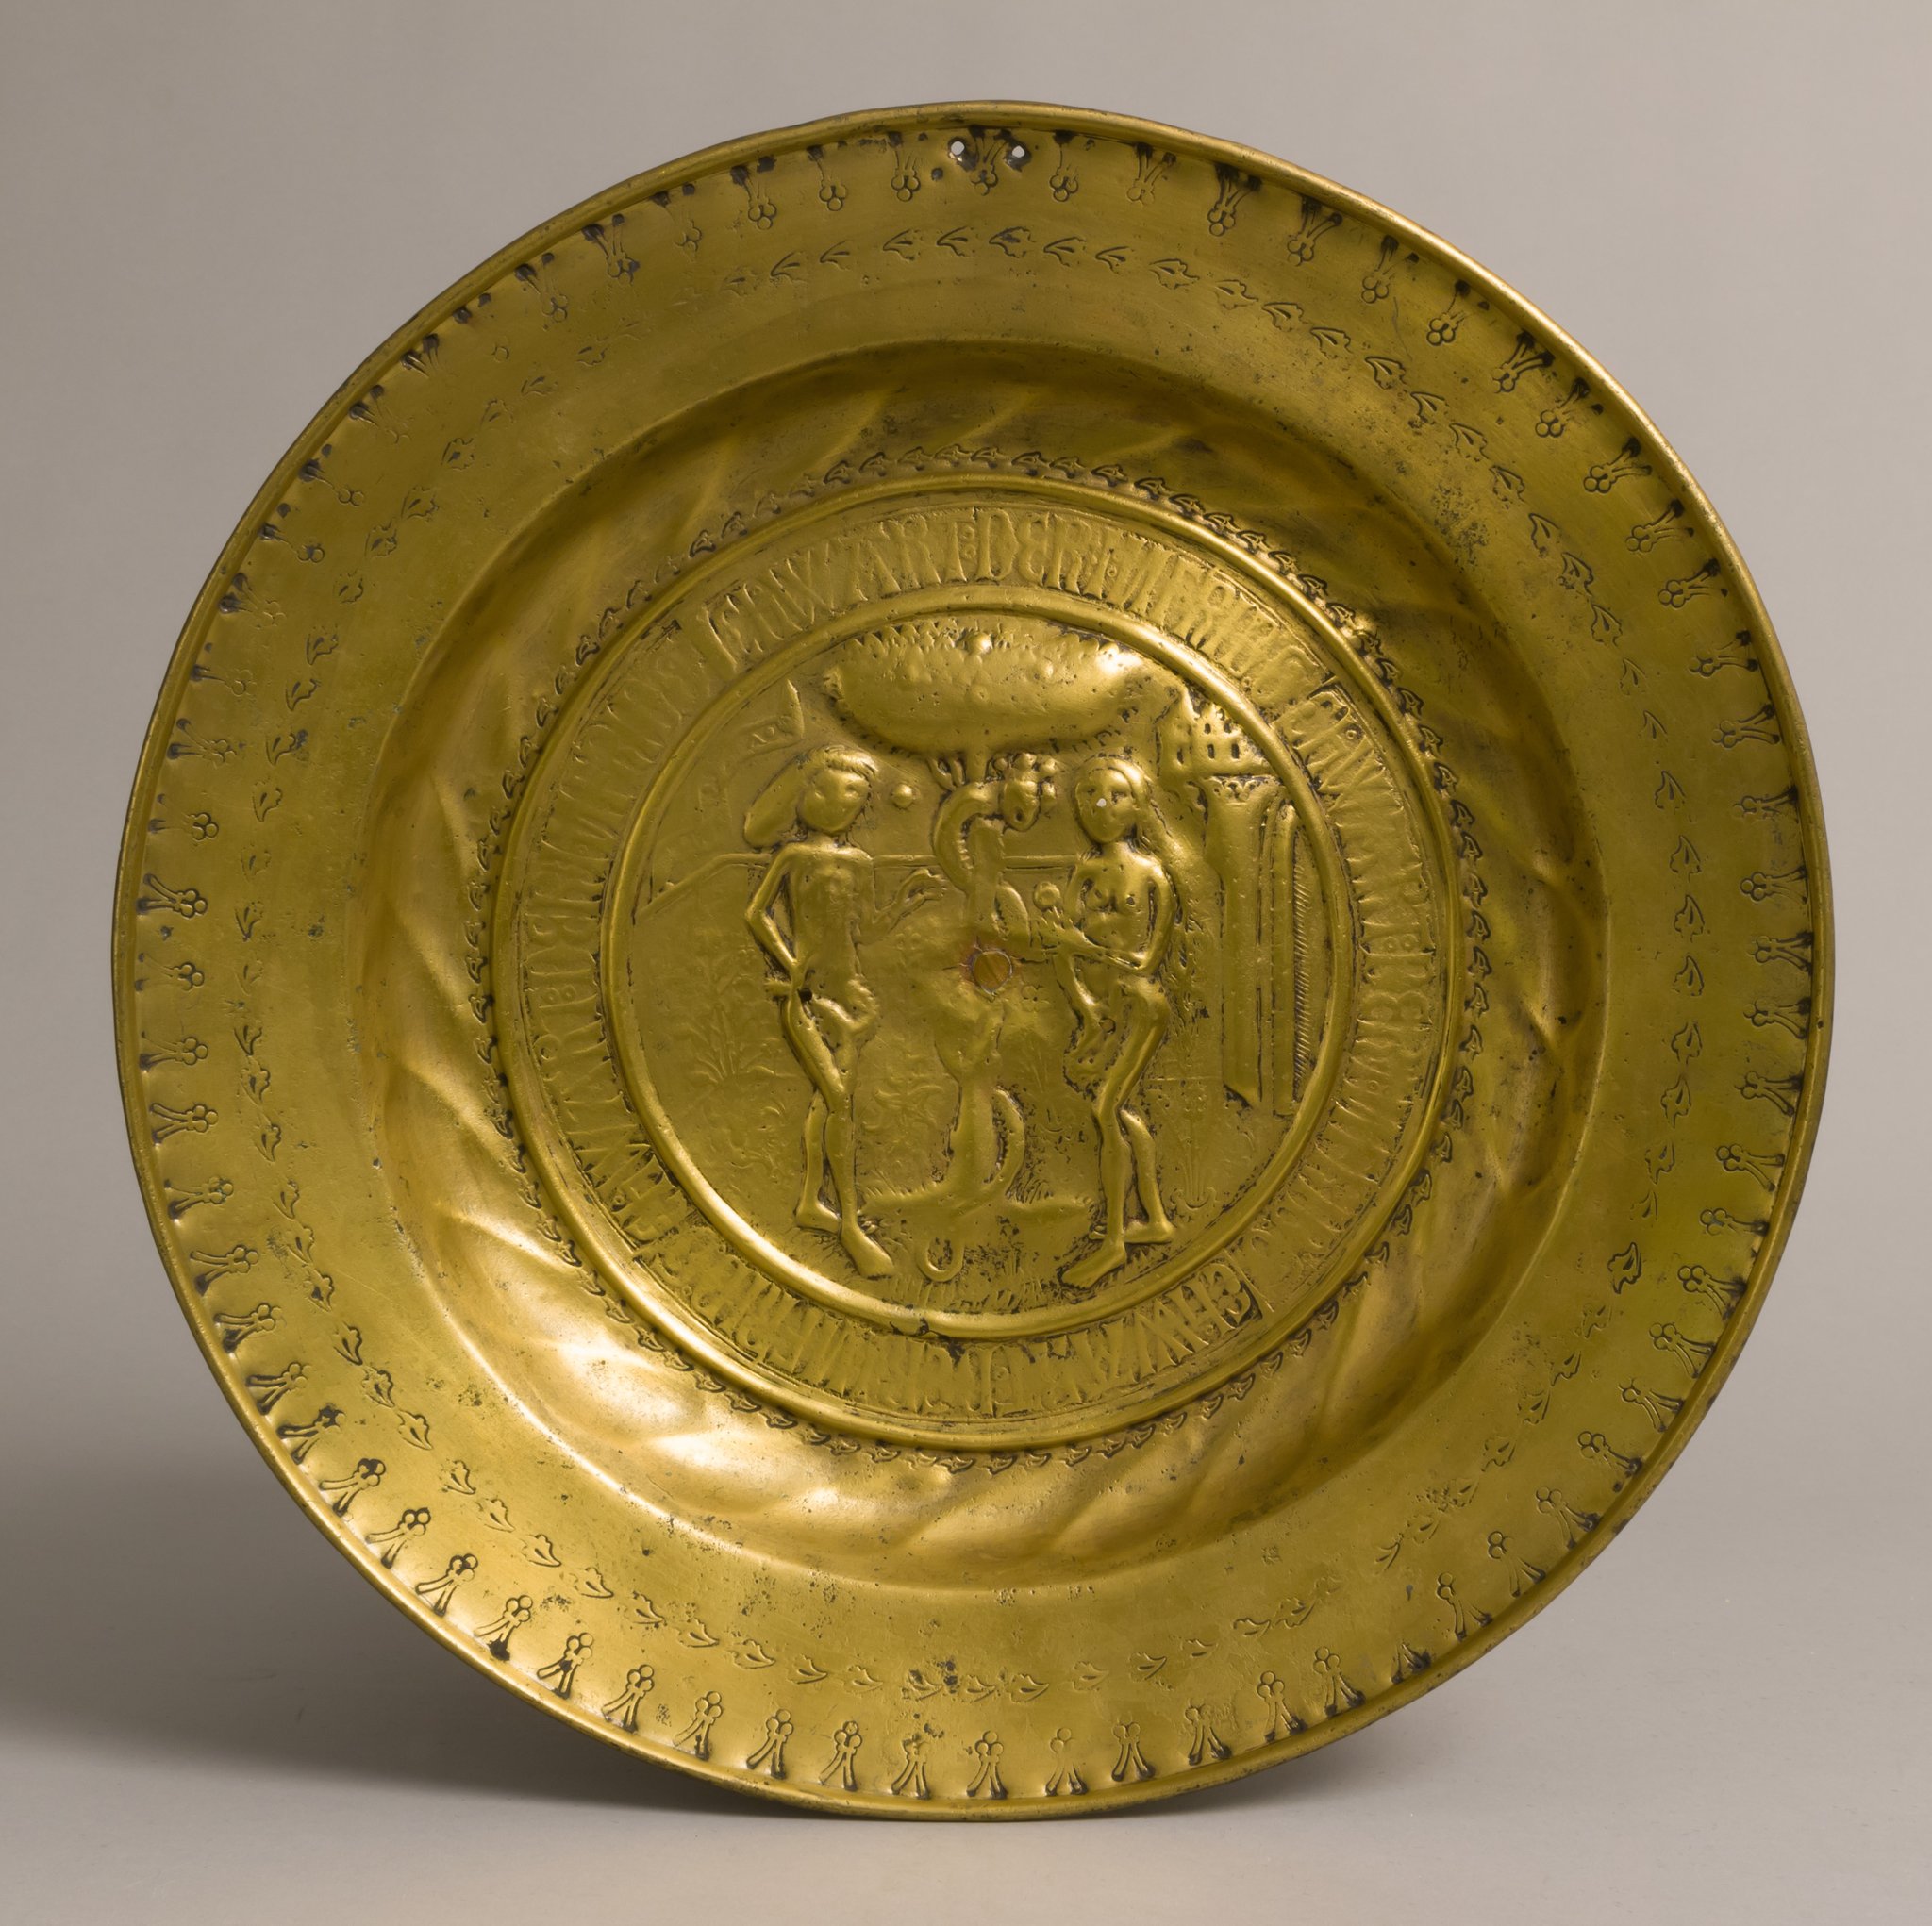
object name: dish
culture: german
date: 1501-1533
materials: brass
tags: snakes,adam,eve